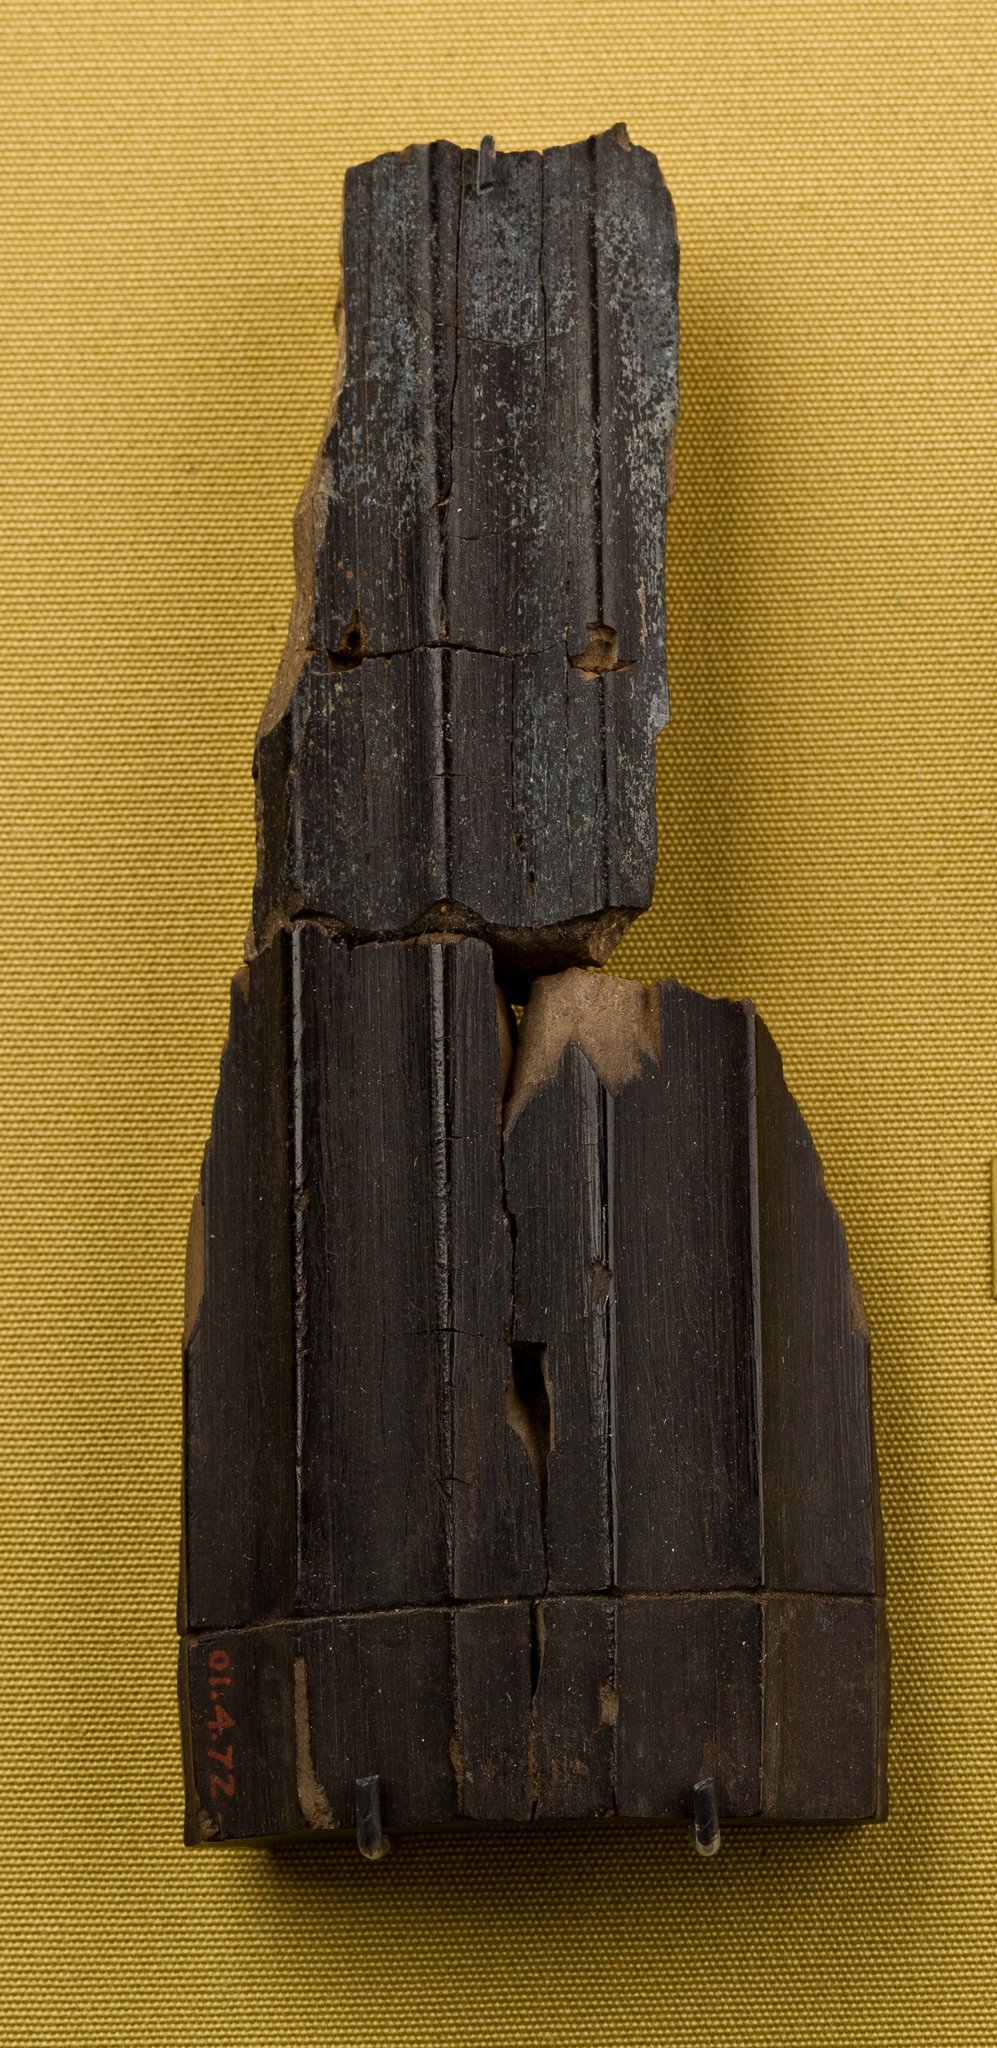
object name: furniture fragment, burned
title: Fragment of burned ivory furniture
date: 3100-2900 BCE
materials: ivory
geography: egypt